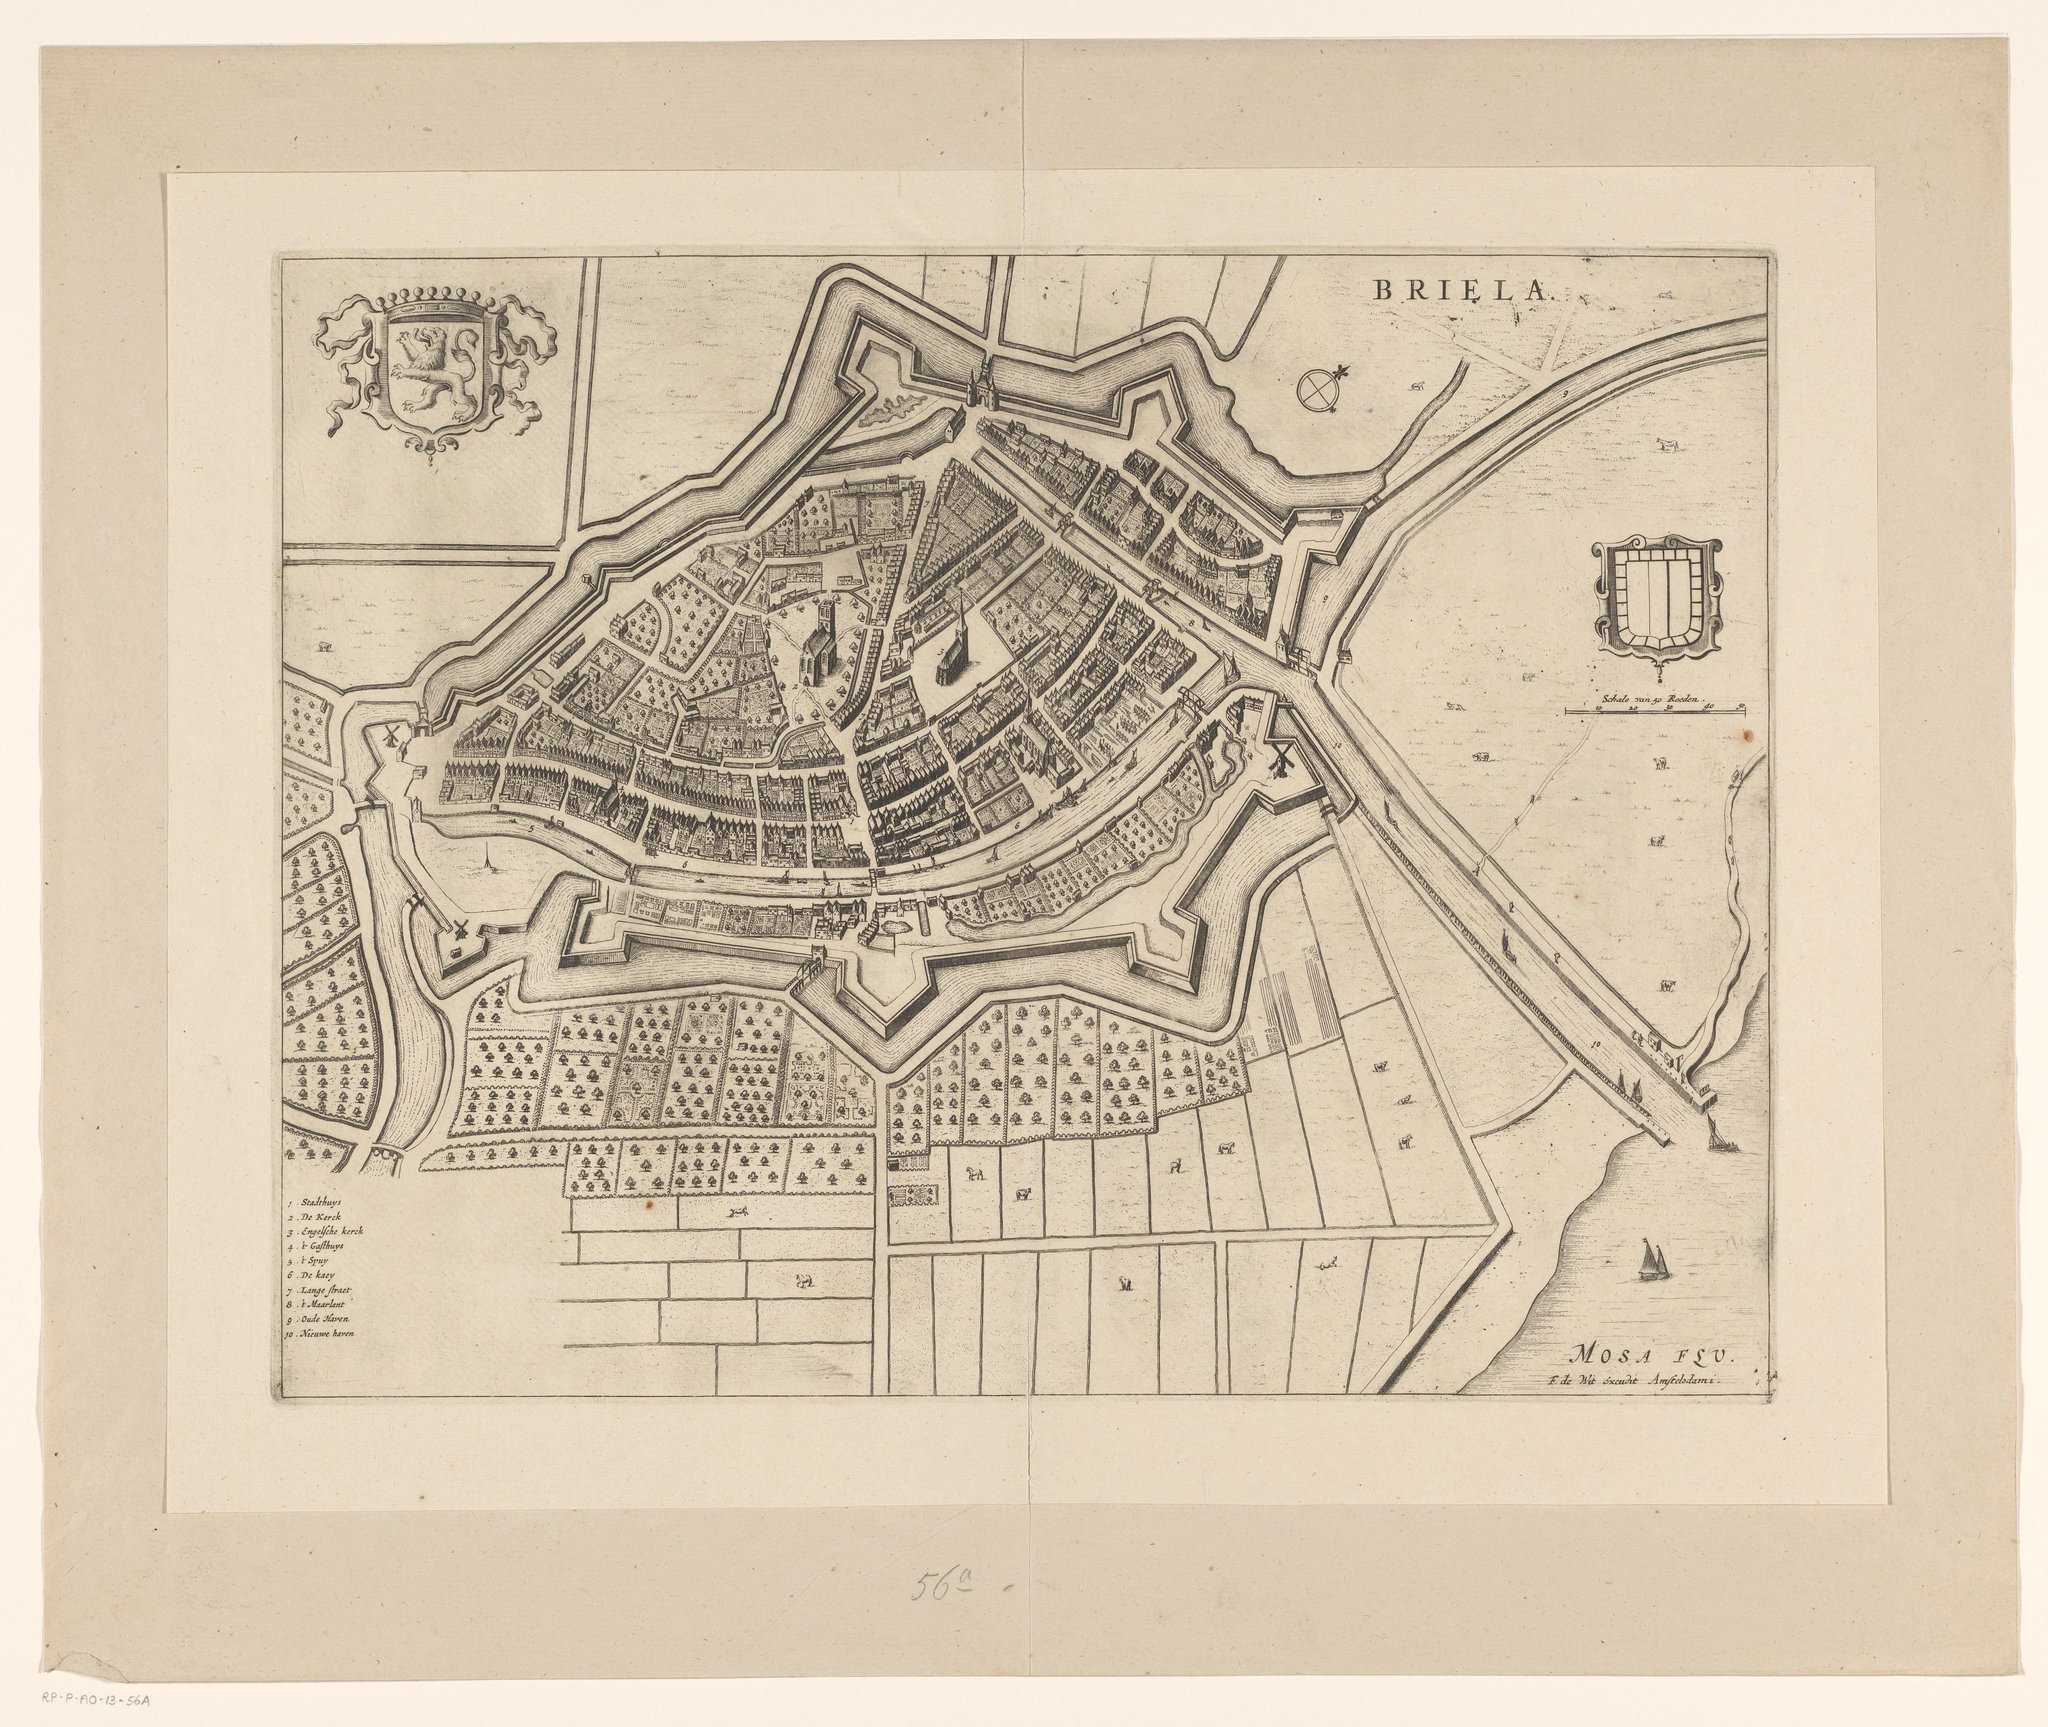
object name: print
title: Plattegrond van Brielle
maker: Anonymous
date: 1649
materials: paper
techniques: engraving, etching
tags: coat of arms (as symbol of the state, etc.) (+ city; municipal), maps of cities, coat of arms (as symbol of the state, etc.) (+ province; provincial), brielle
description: Deze staat van prent ook gebruikt in sommige uitgaven van: Theatrum ichnographicum omnium urbium et praecipuorum oppidorum Belgicarum XVII Provinciarum (…). Amsterdam: Frederik de Wit, ca. 1698-1704. En in: Theatrum ichnographicum omnium urbium et praecipuorum oppidorum Belgicarum XVII Provinciarum (…). Amsterdam: Frederik de Wit, ca. 1700-1710. En in: Aa, Pieter van der. La galerie agreable du monde (...). 66 delen. Leiden: Pieter van der Aa, 1728, dl. 18.